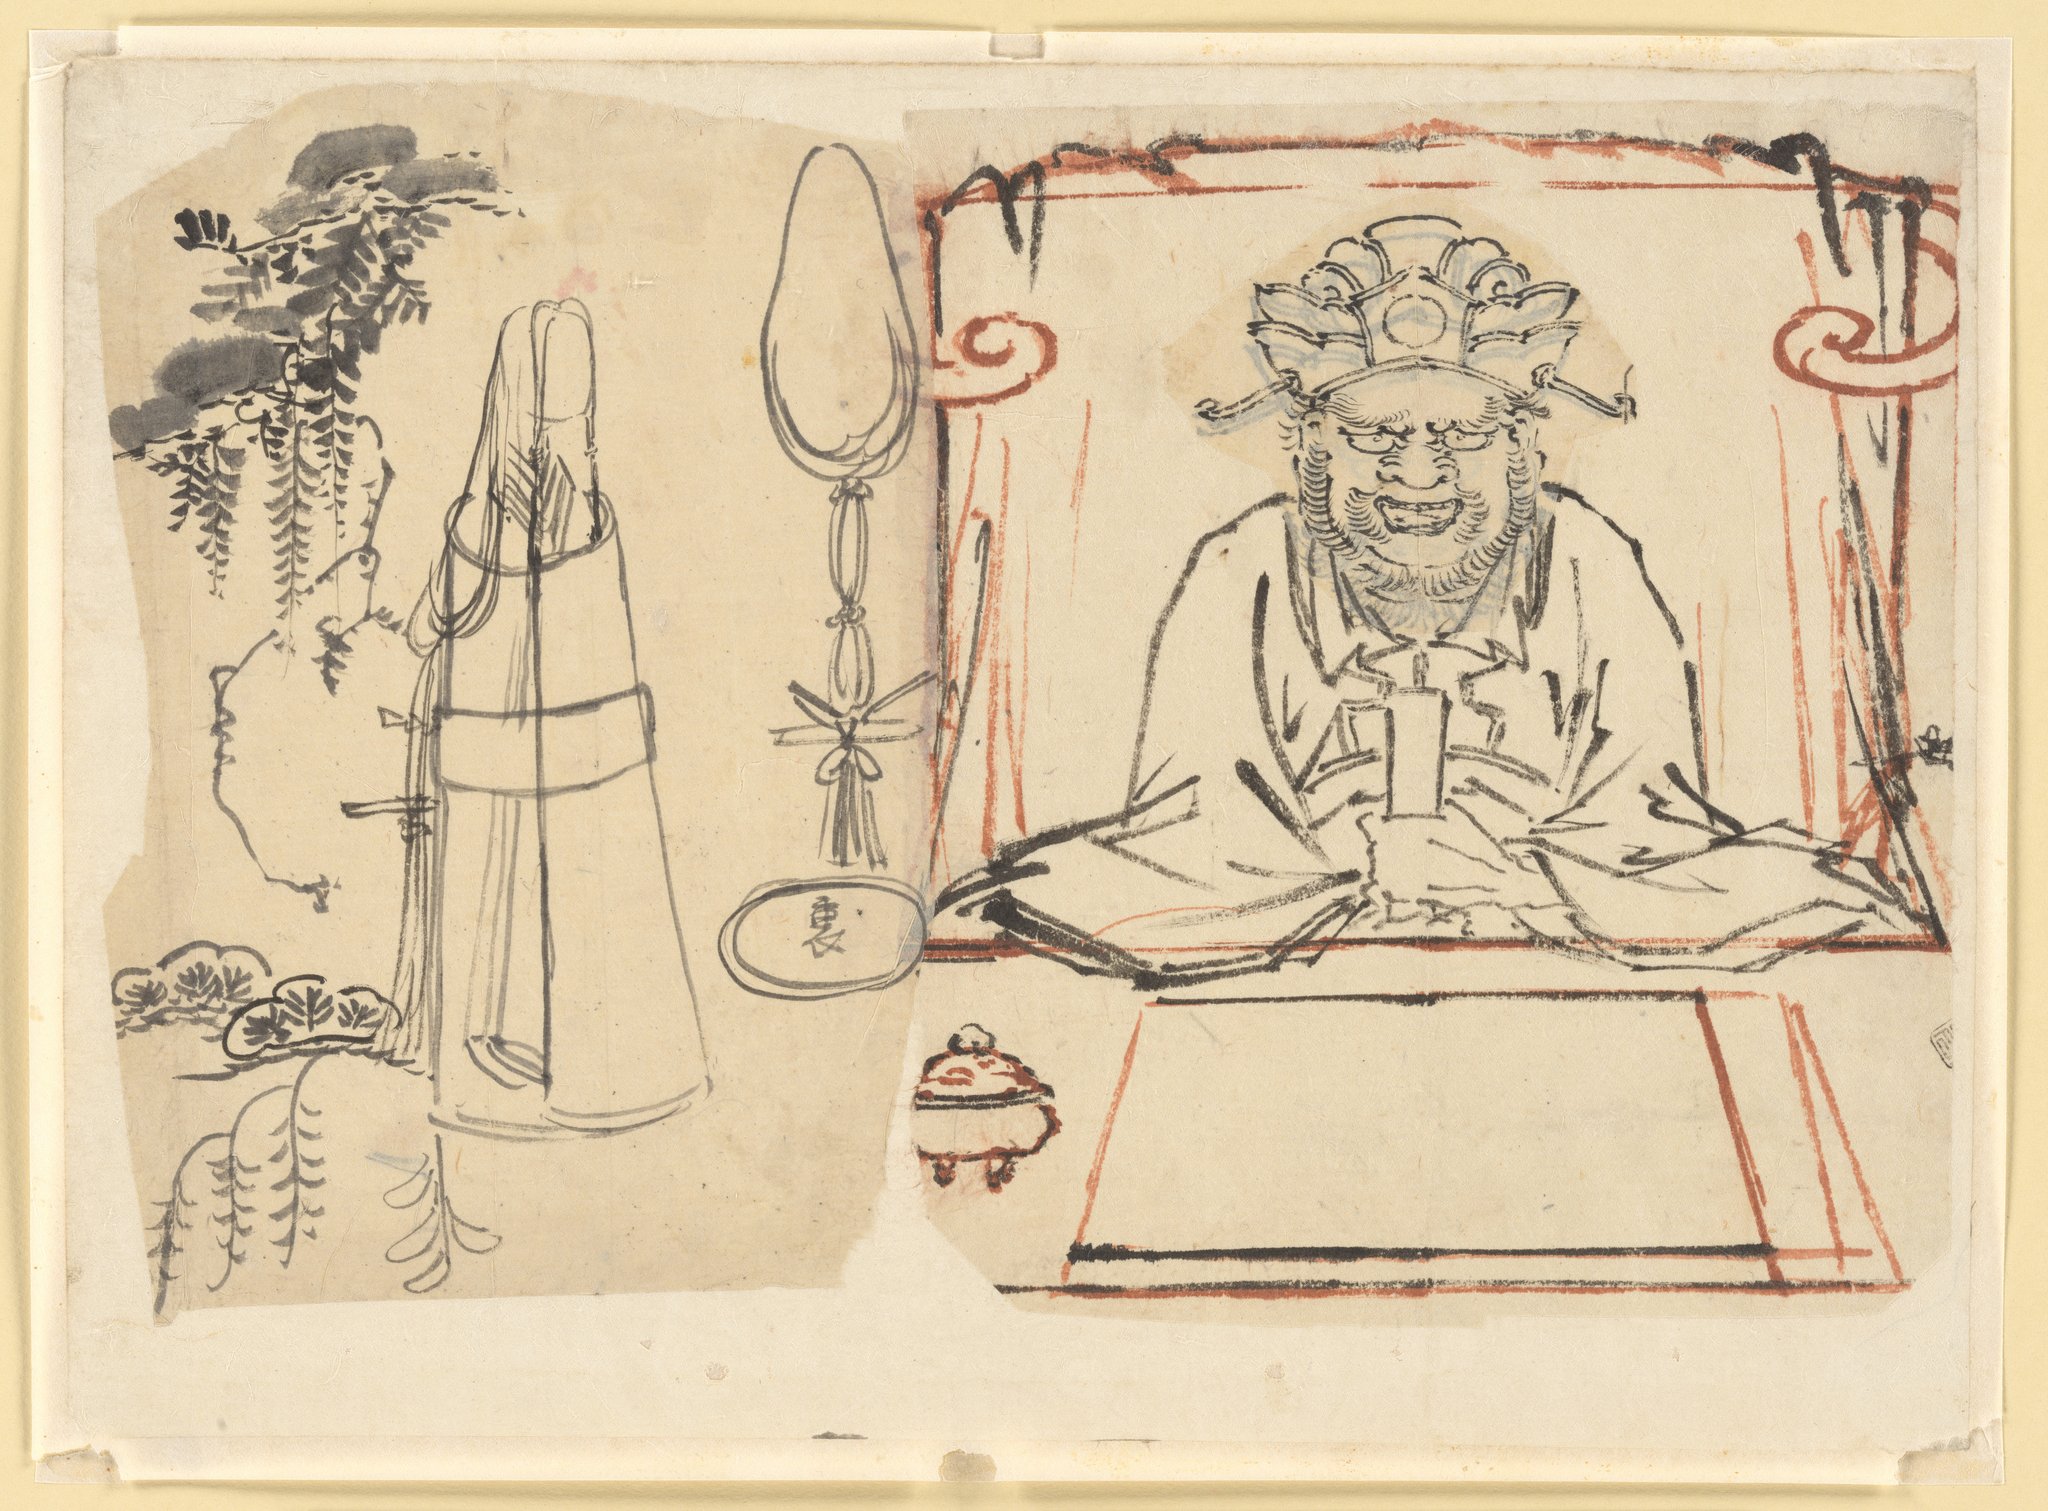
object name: painting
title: Juima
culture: japanese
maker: katsushika hokusai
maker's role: artist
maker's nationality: japanese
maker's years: 1760-1849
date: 1701-1900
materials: ink, paper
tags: men